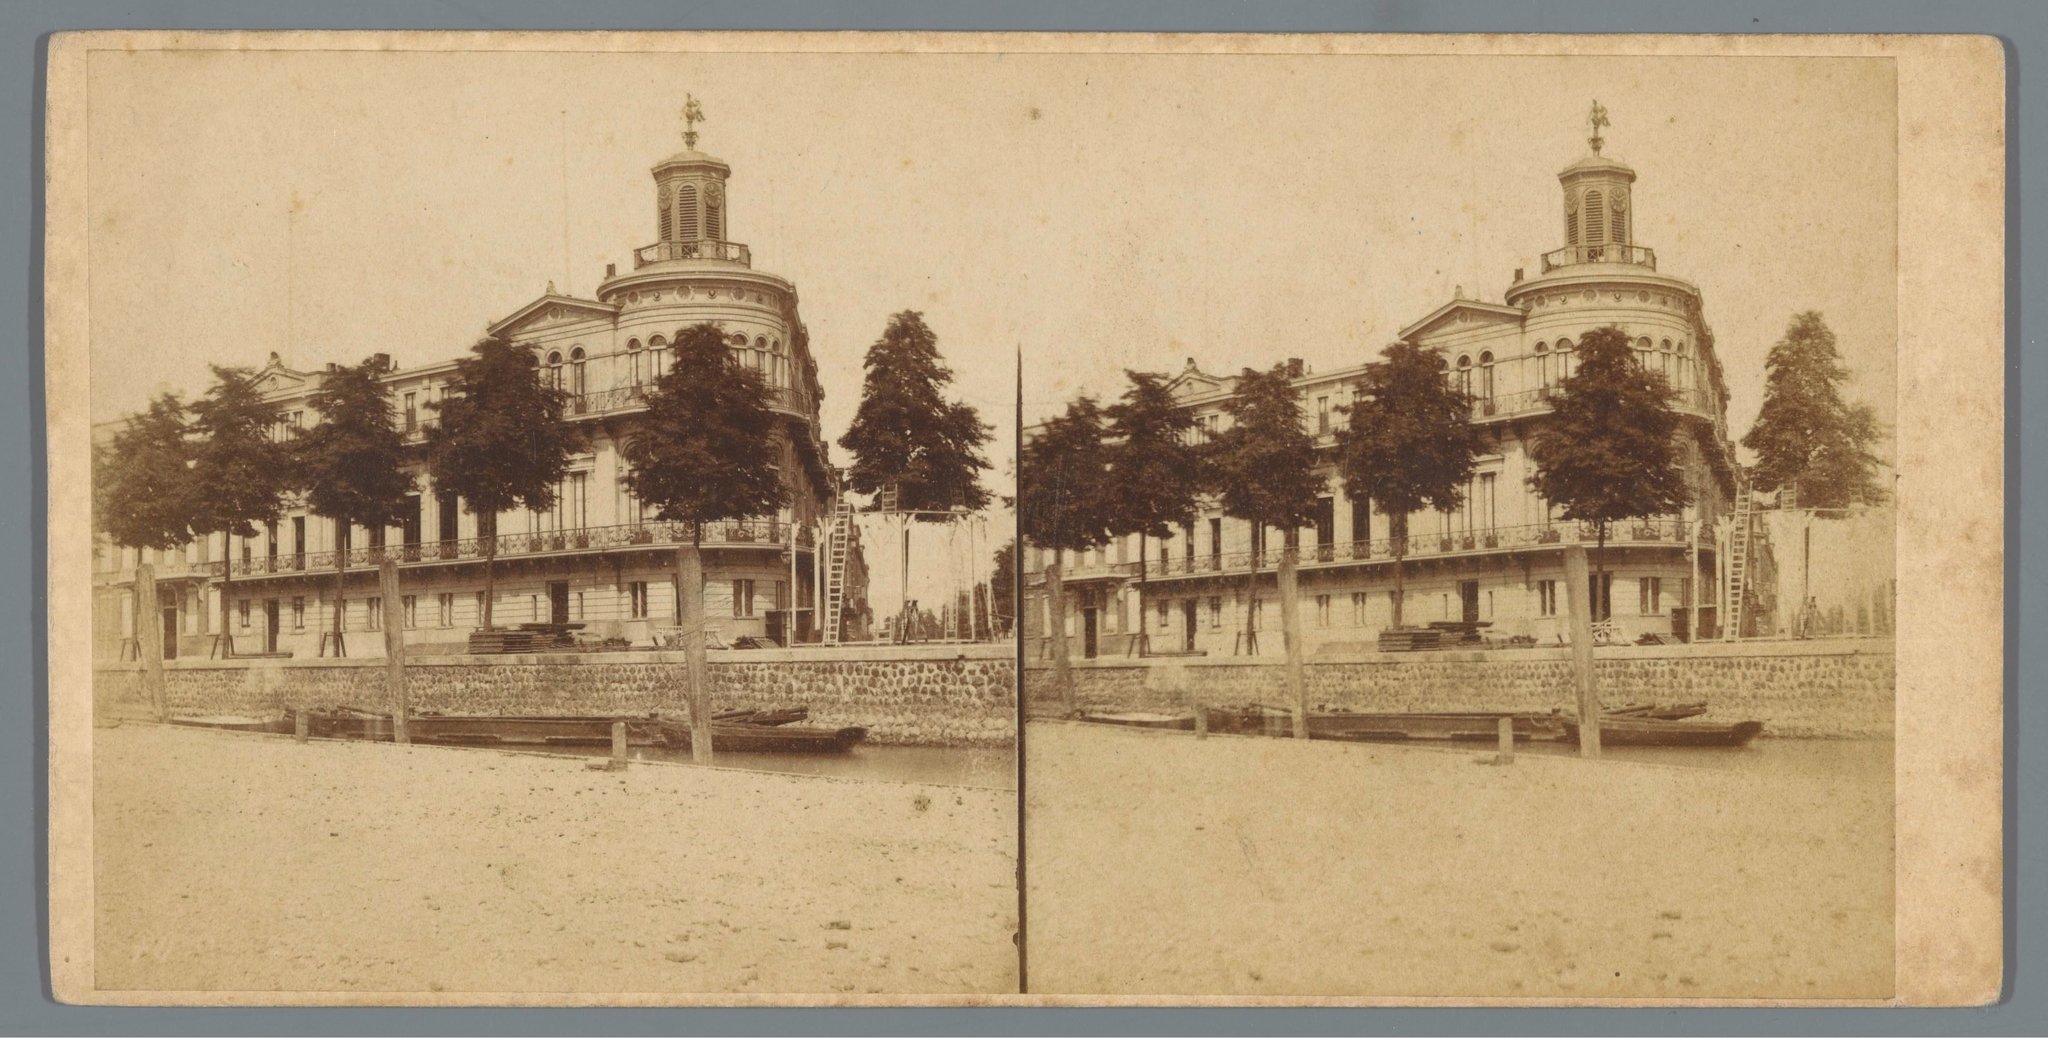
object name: stereograph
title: Gebouw van de Koninklijke Yachtvereniging, Rotterdam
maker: Anonymous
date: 1857-1870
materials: cardboard, paper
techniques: albumen print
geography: rotterdam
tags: club, meeting place, rotterdam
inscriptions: inscription: ‘Rotterdam/ Nederland’, number: ‘71’, number: ‘No. 56’, inscription: ‘Rotterdam’